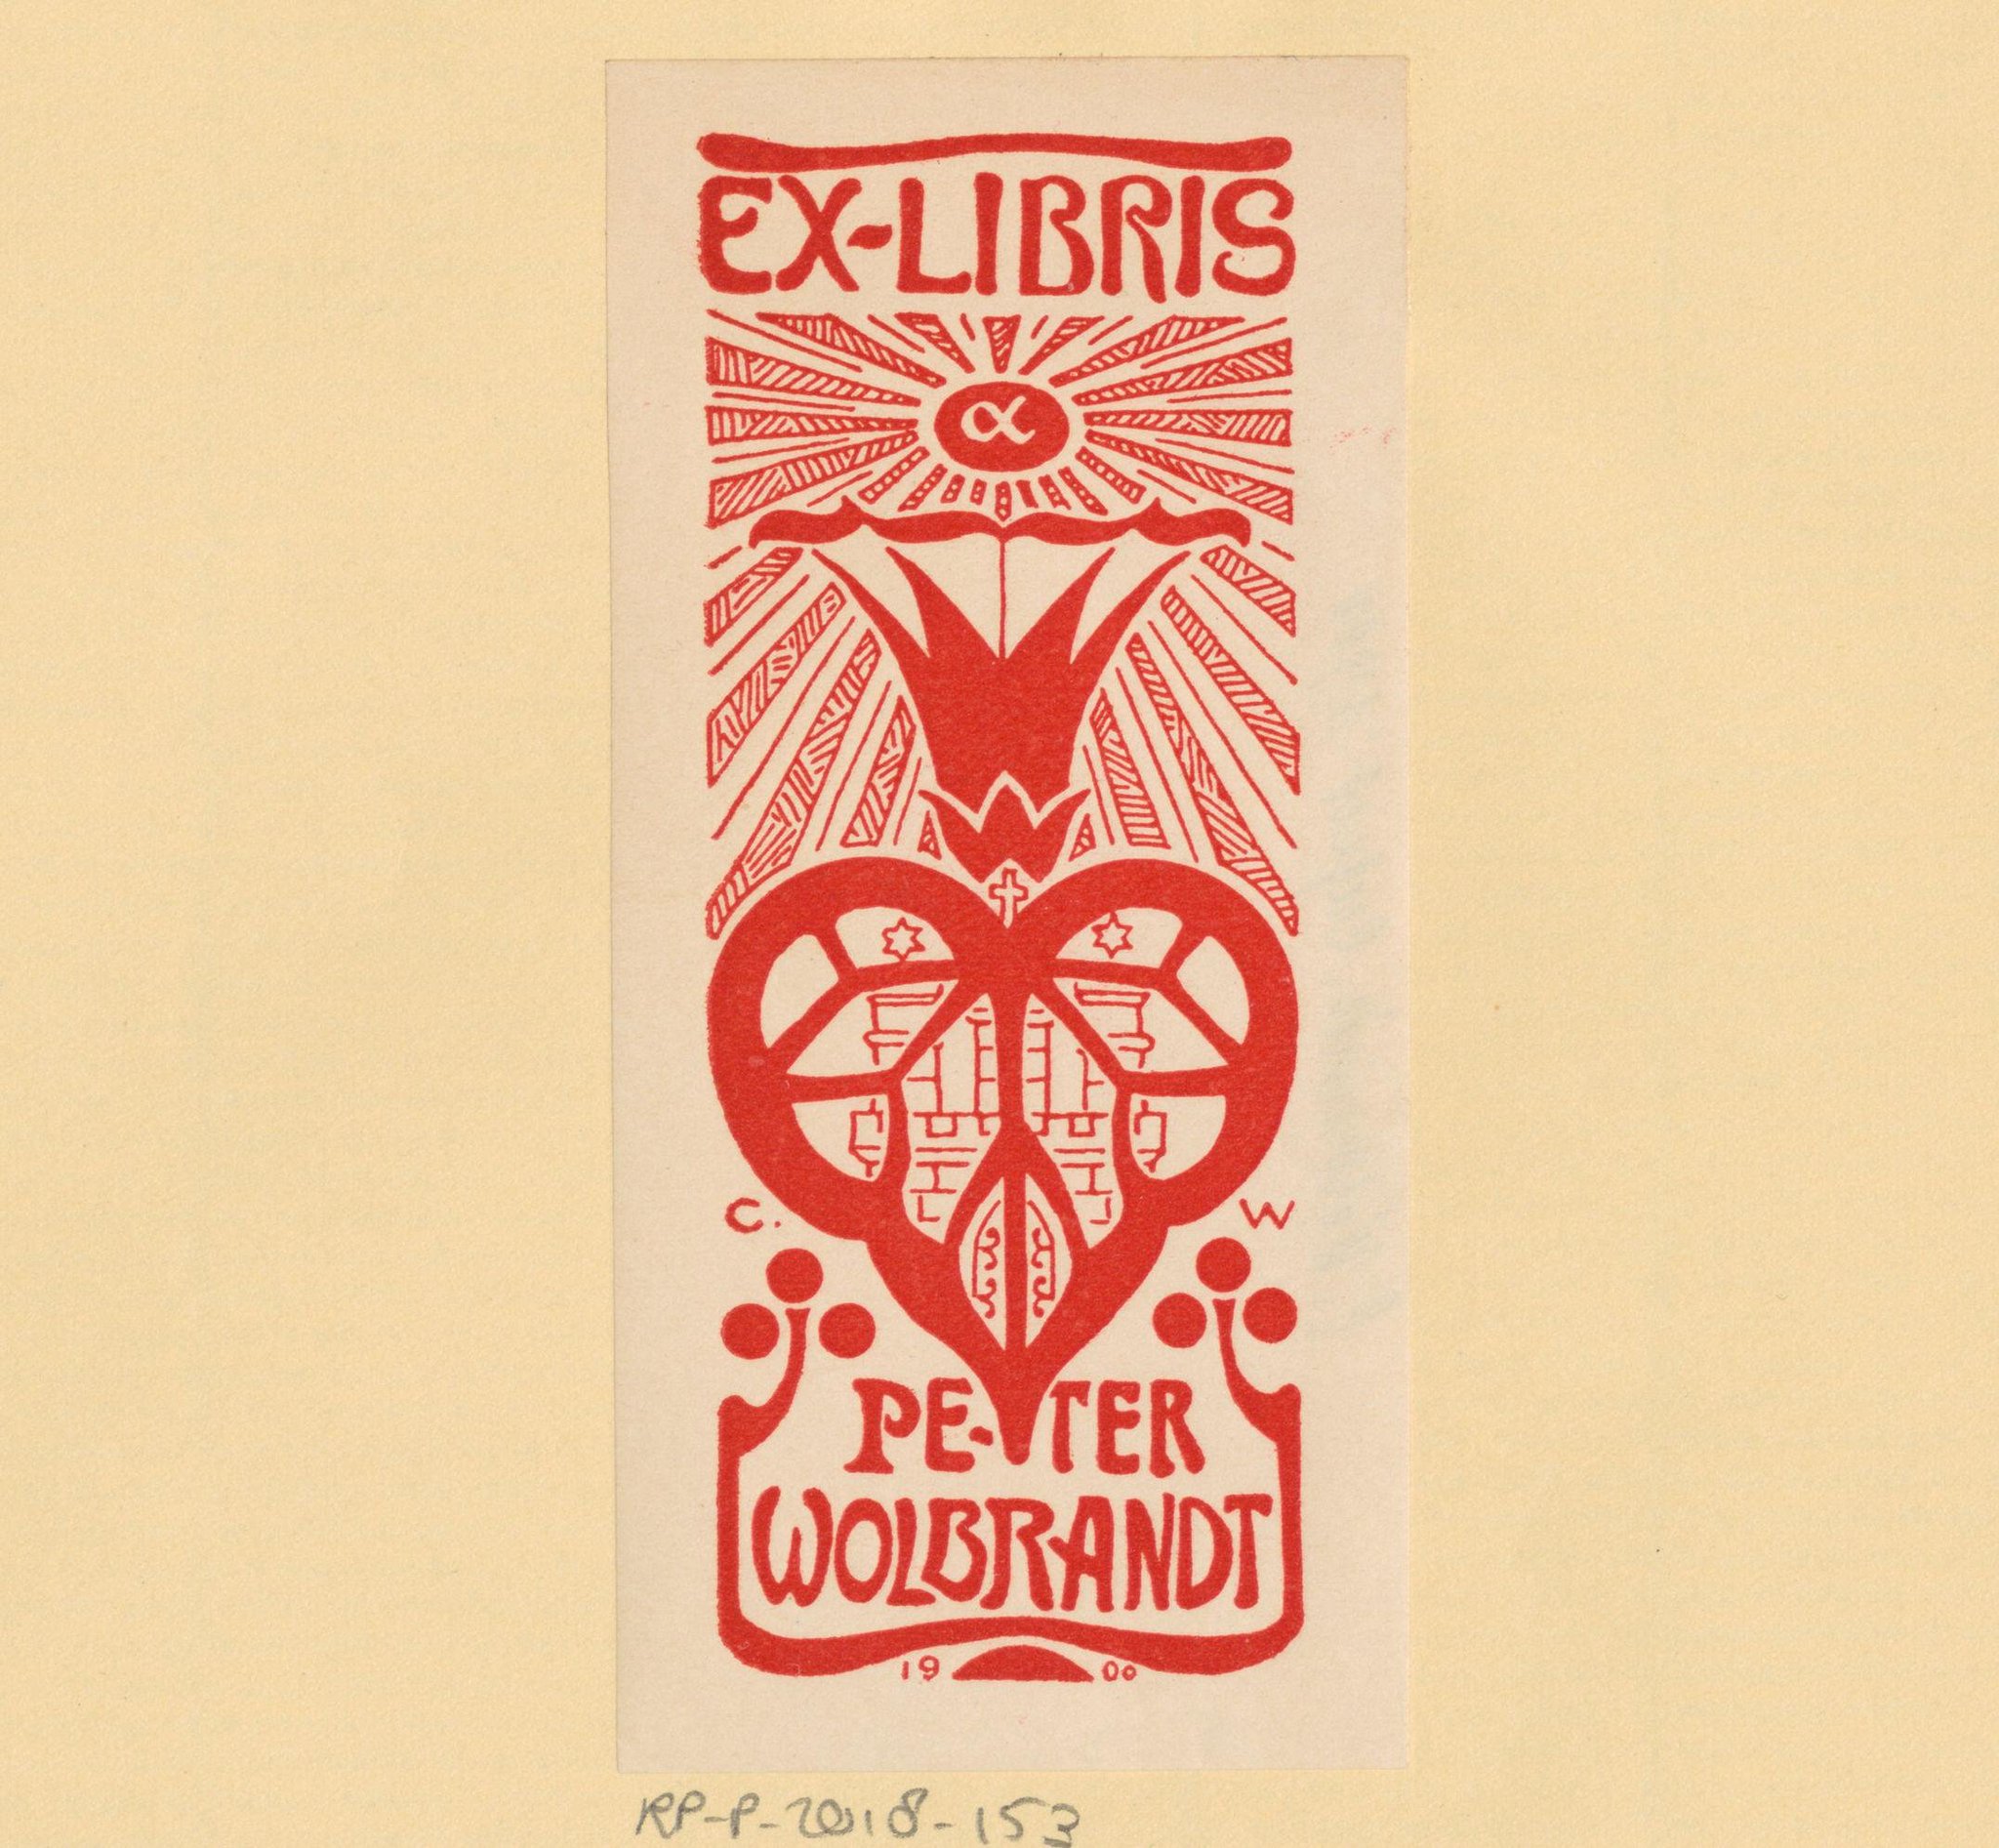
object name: bookplate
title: Ex libris van Peter Wolbrandt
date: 1900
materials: paper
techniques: printing block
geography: germany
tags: peter p. wolbrandt, parts of church exterior and annexes: campanile, flowers, alpha and omega ~ symbol of god the father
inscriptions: date